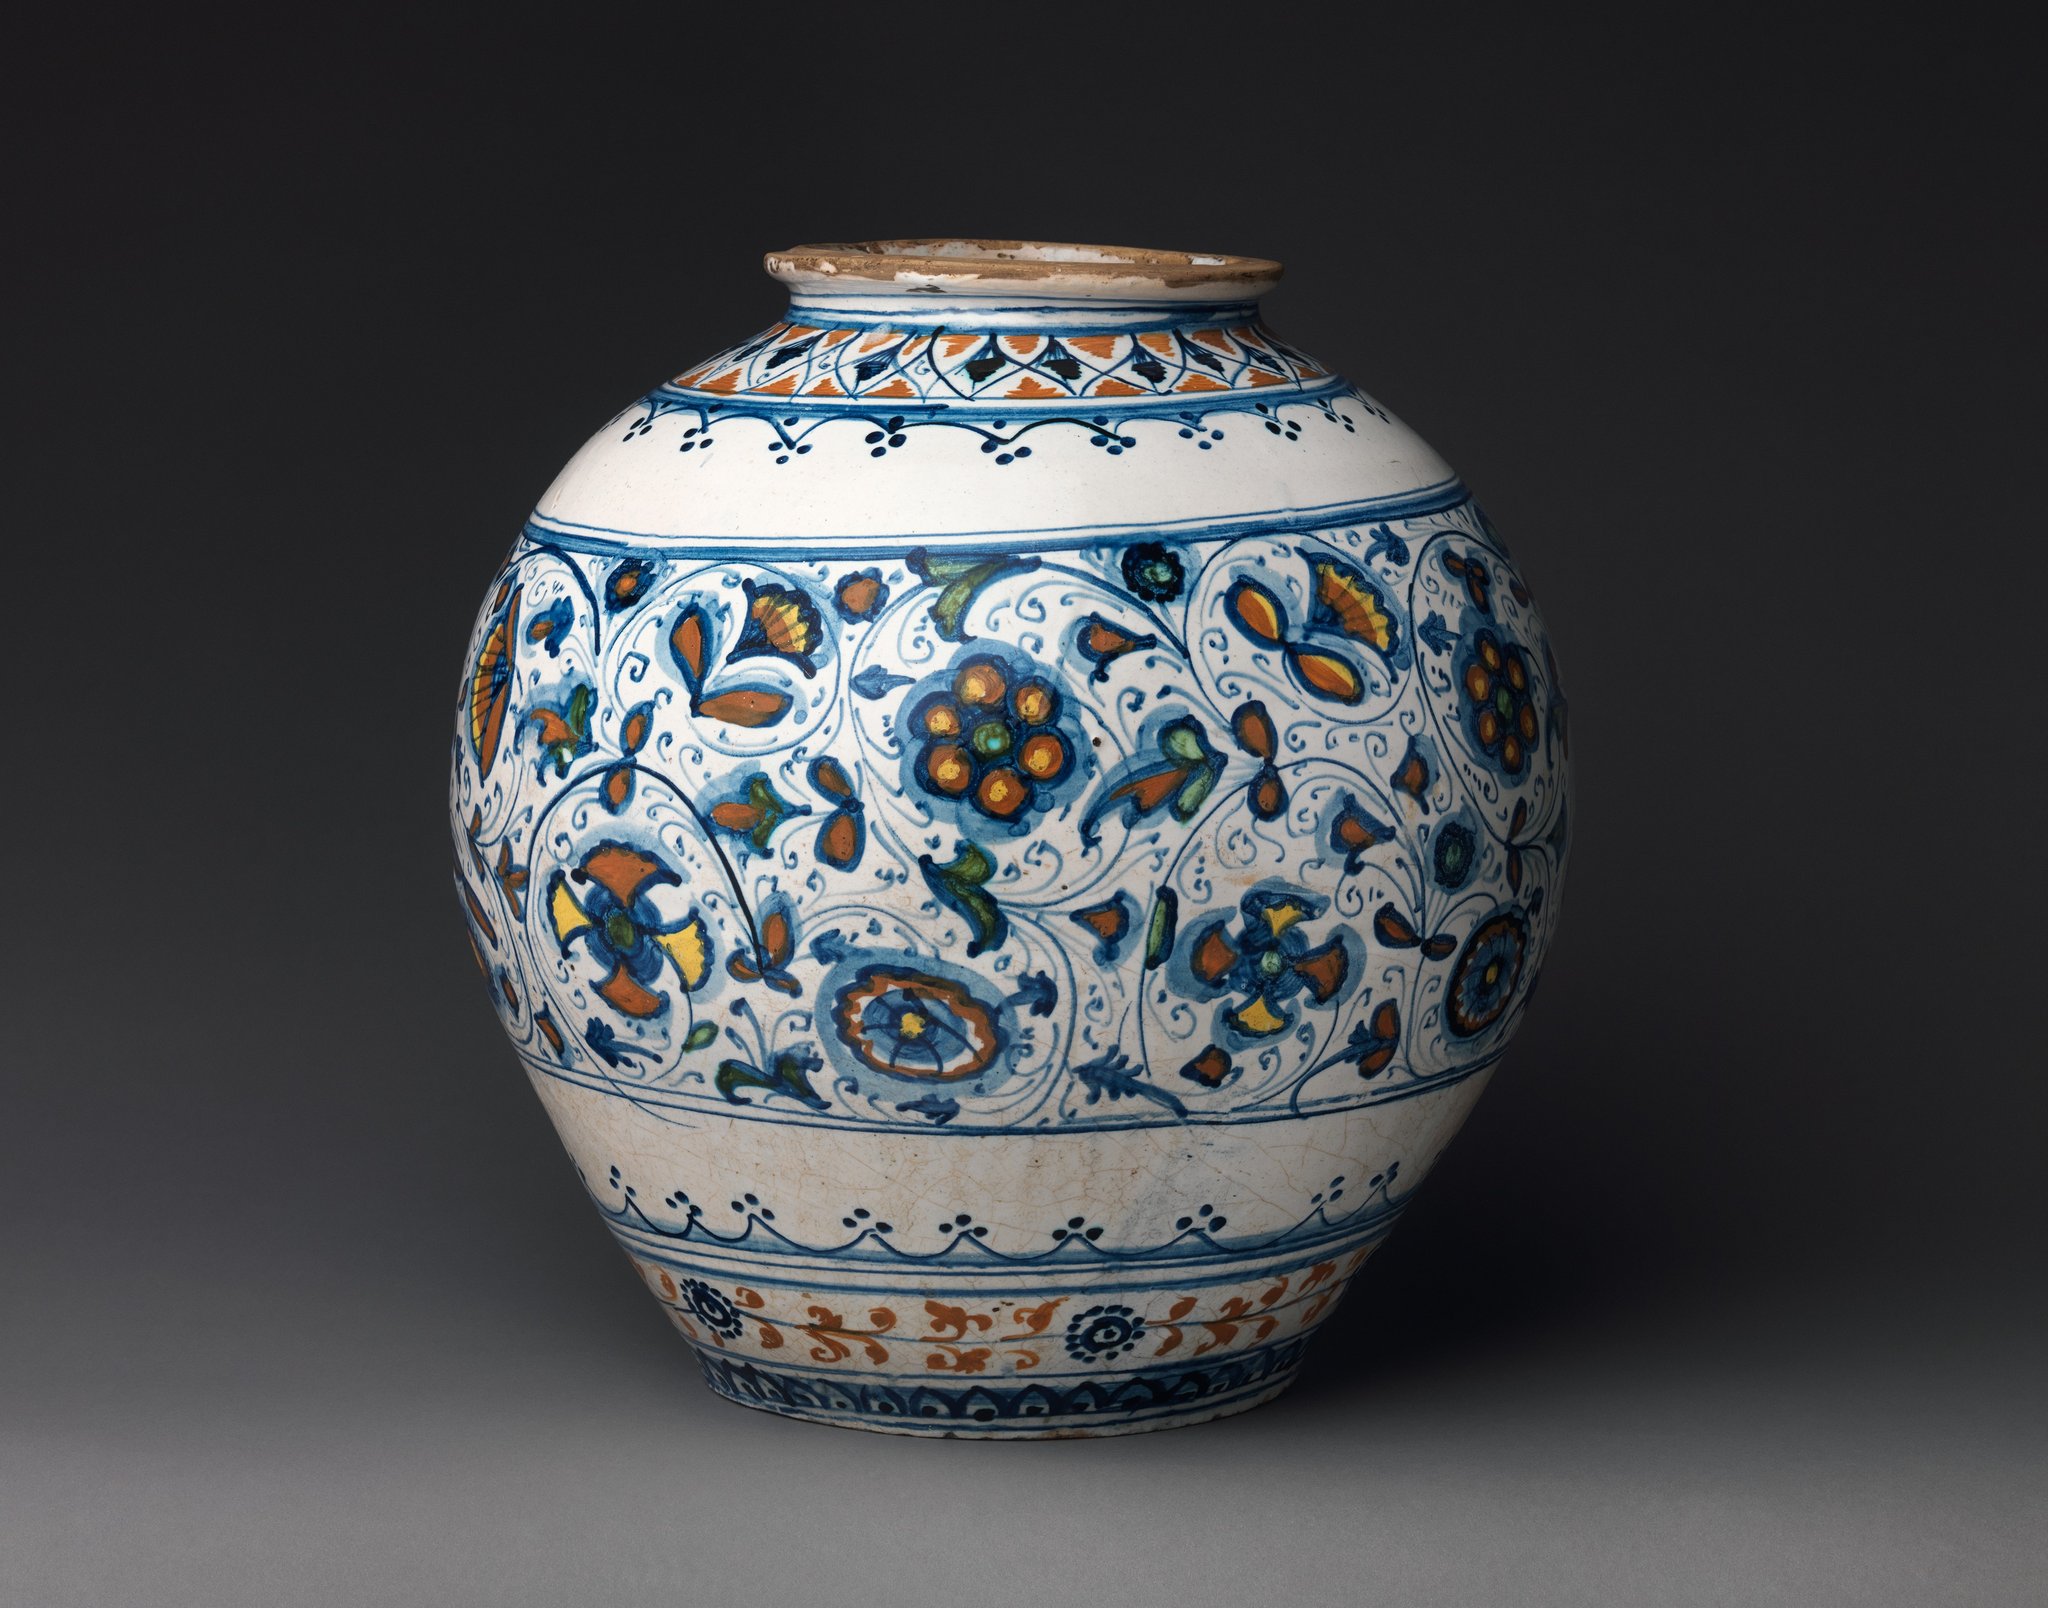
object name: storage jar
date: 1500-1525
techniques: maiolica, glazing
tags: flowers